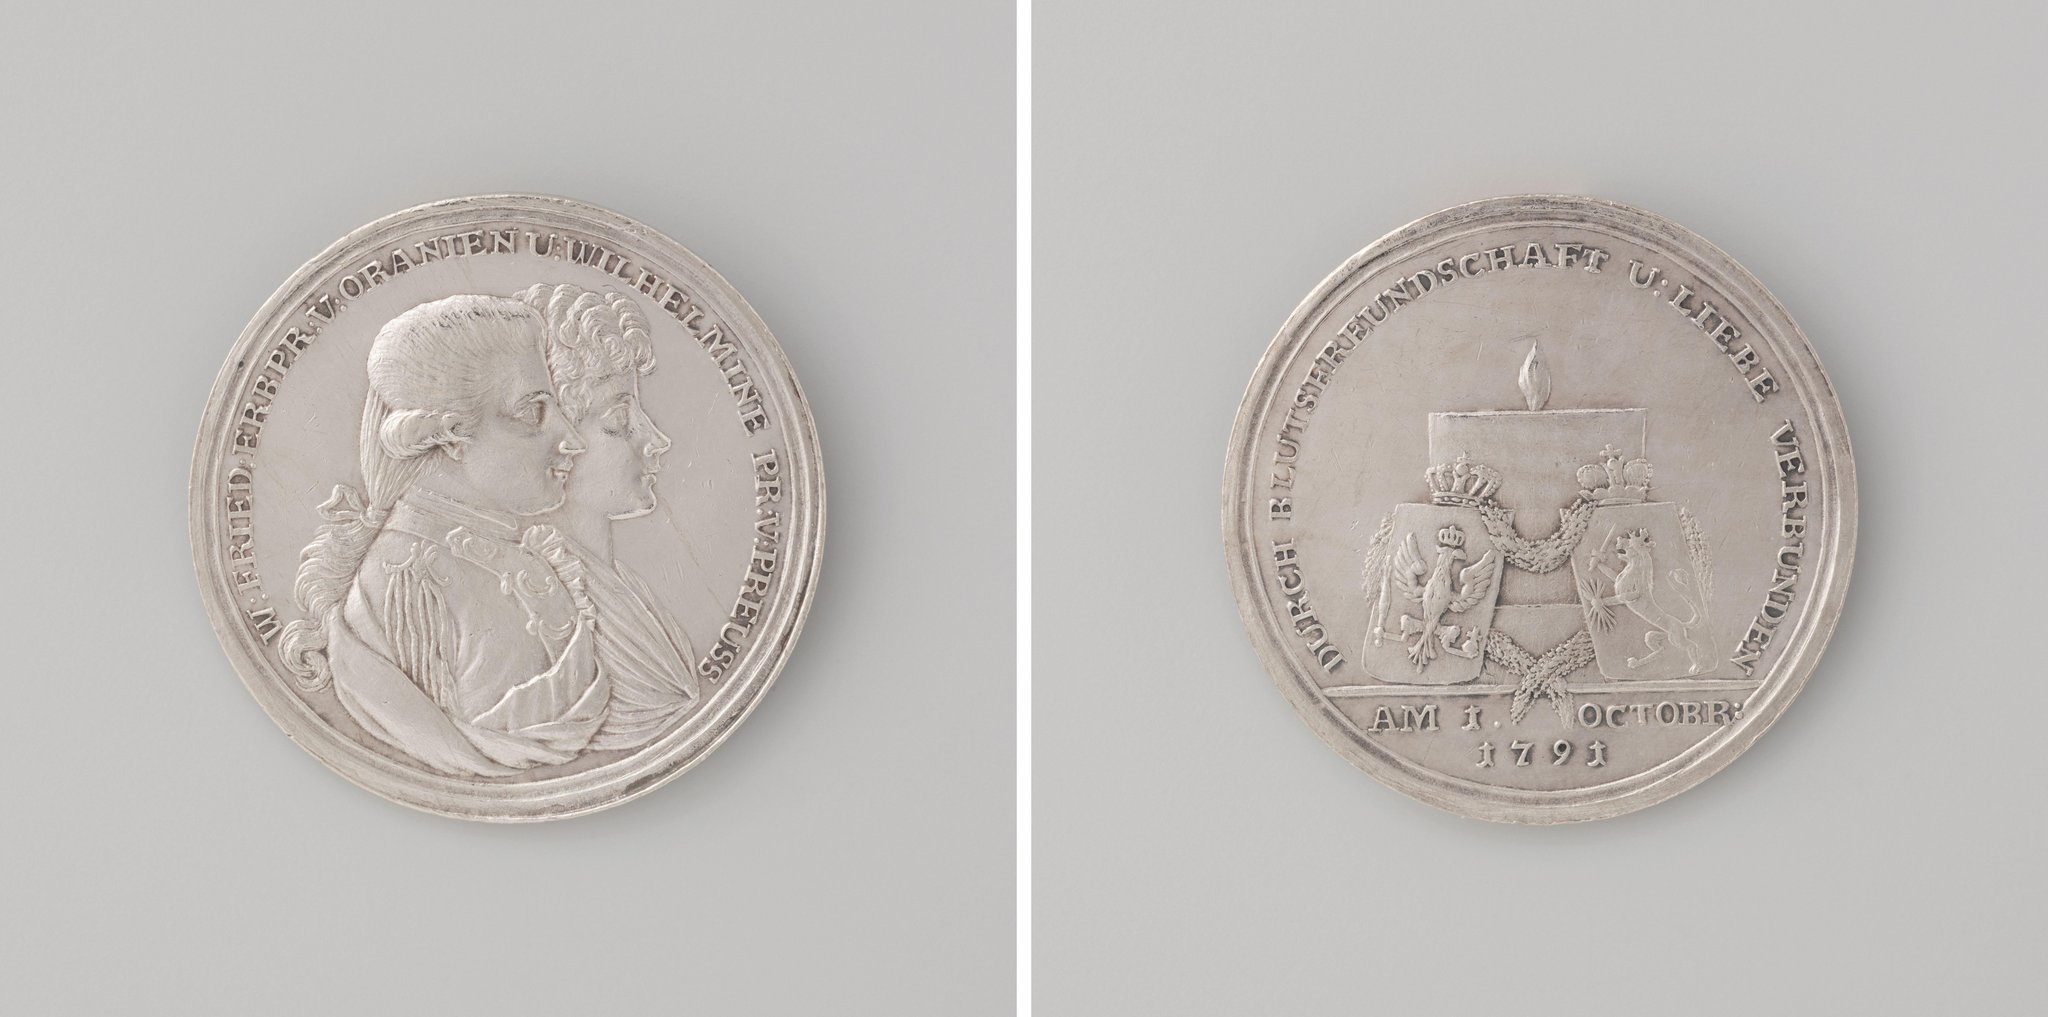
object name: history medal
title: Huwelijk van Willem Frederik, erfprins van Oranje-Nassau en Fredrika Louise Wilhelmina, prinses van Pruisen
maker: Anonymous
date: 1791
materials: silver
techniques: striking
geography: germany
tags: william i of the netherlands, berlin, the hague, wilhelmina frederica louisa (koningin der nederlanden)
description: Zilveren penning. Voorzijde: borststuk man en vrouw binnen omschrift. Keerzijde: brandend altaar, waartegen twee gekroonde, met kransen verenigde wapenschilden staan binnen omschrift; afsnede: opschrift